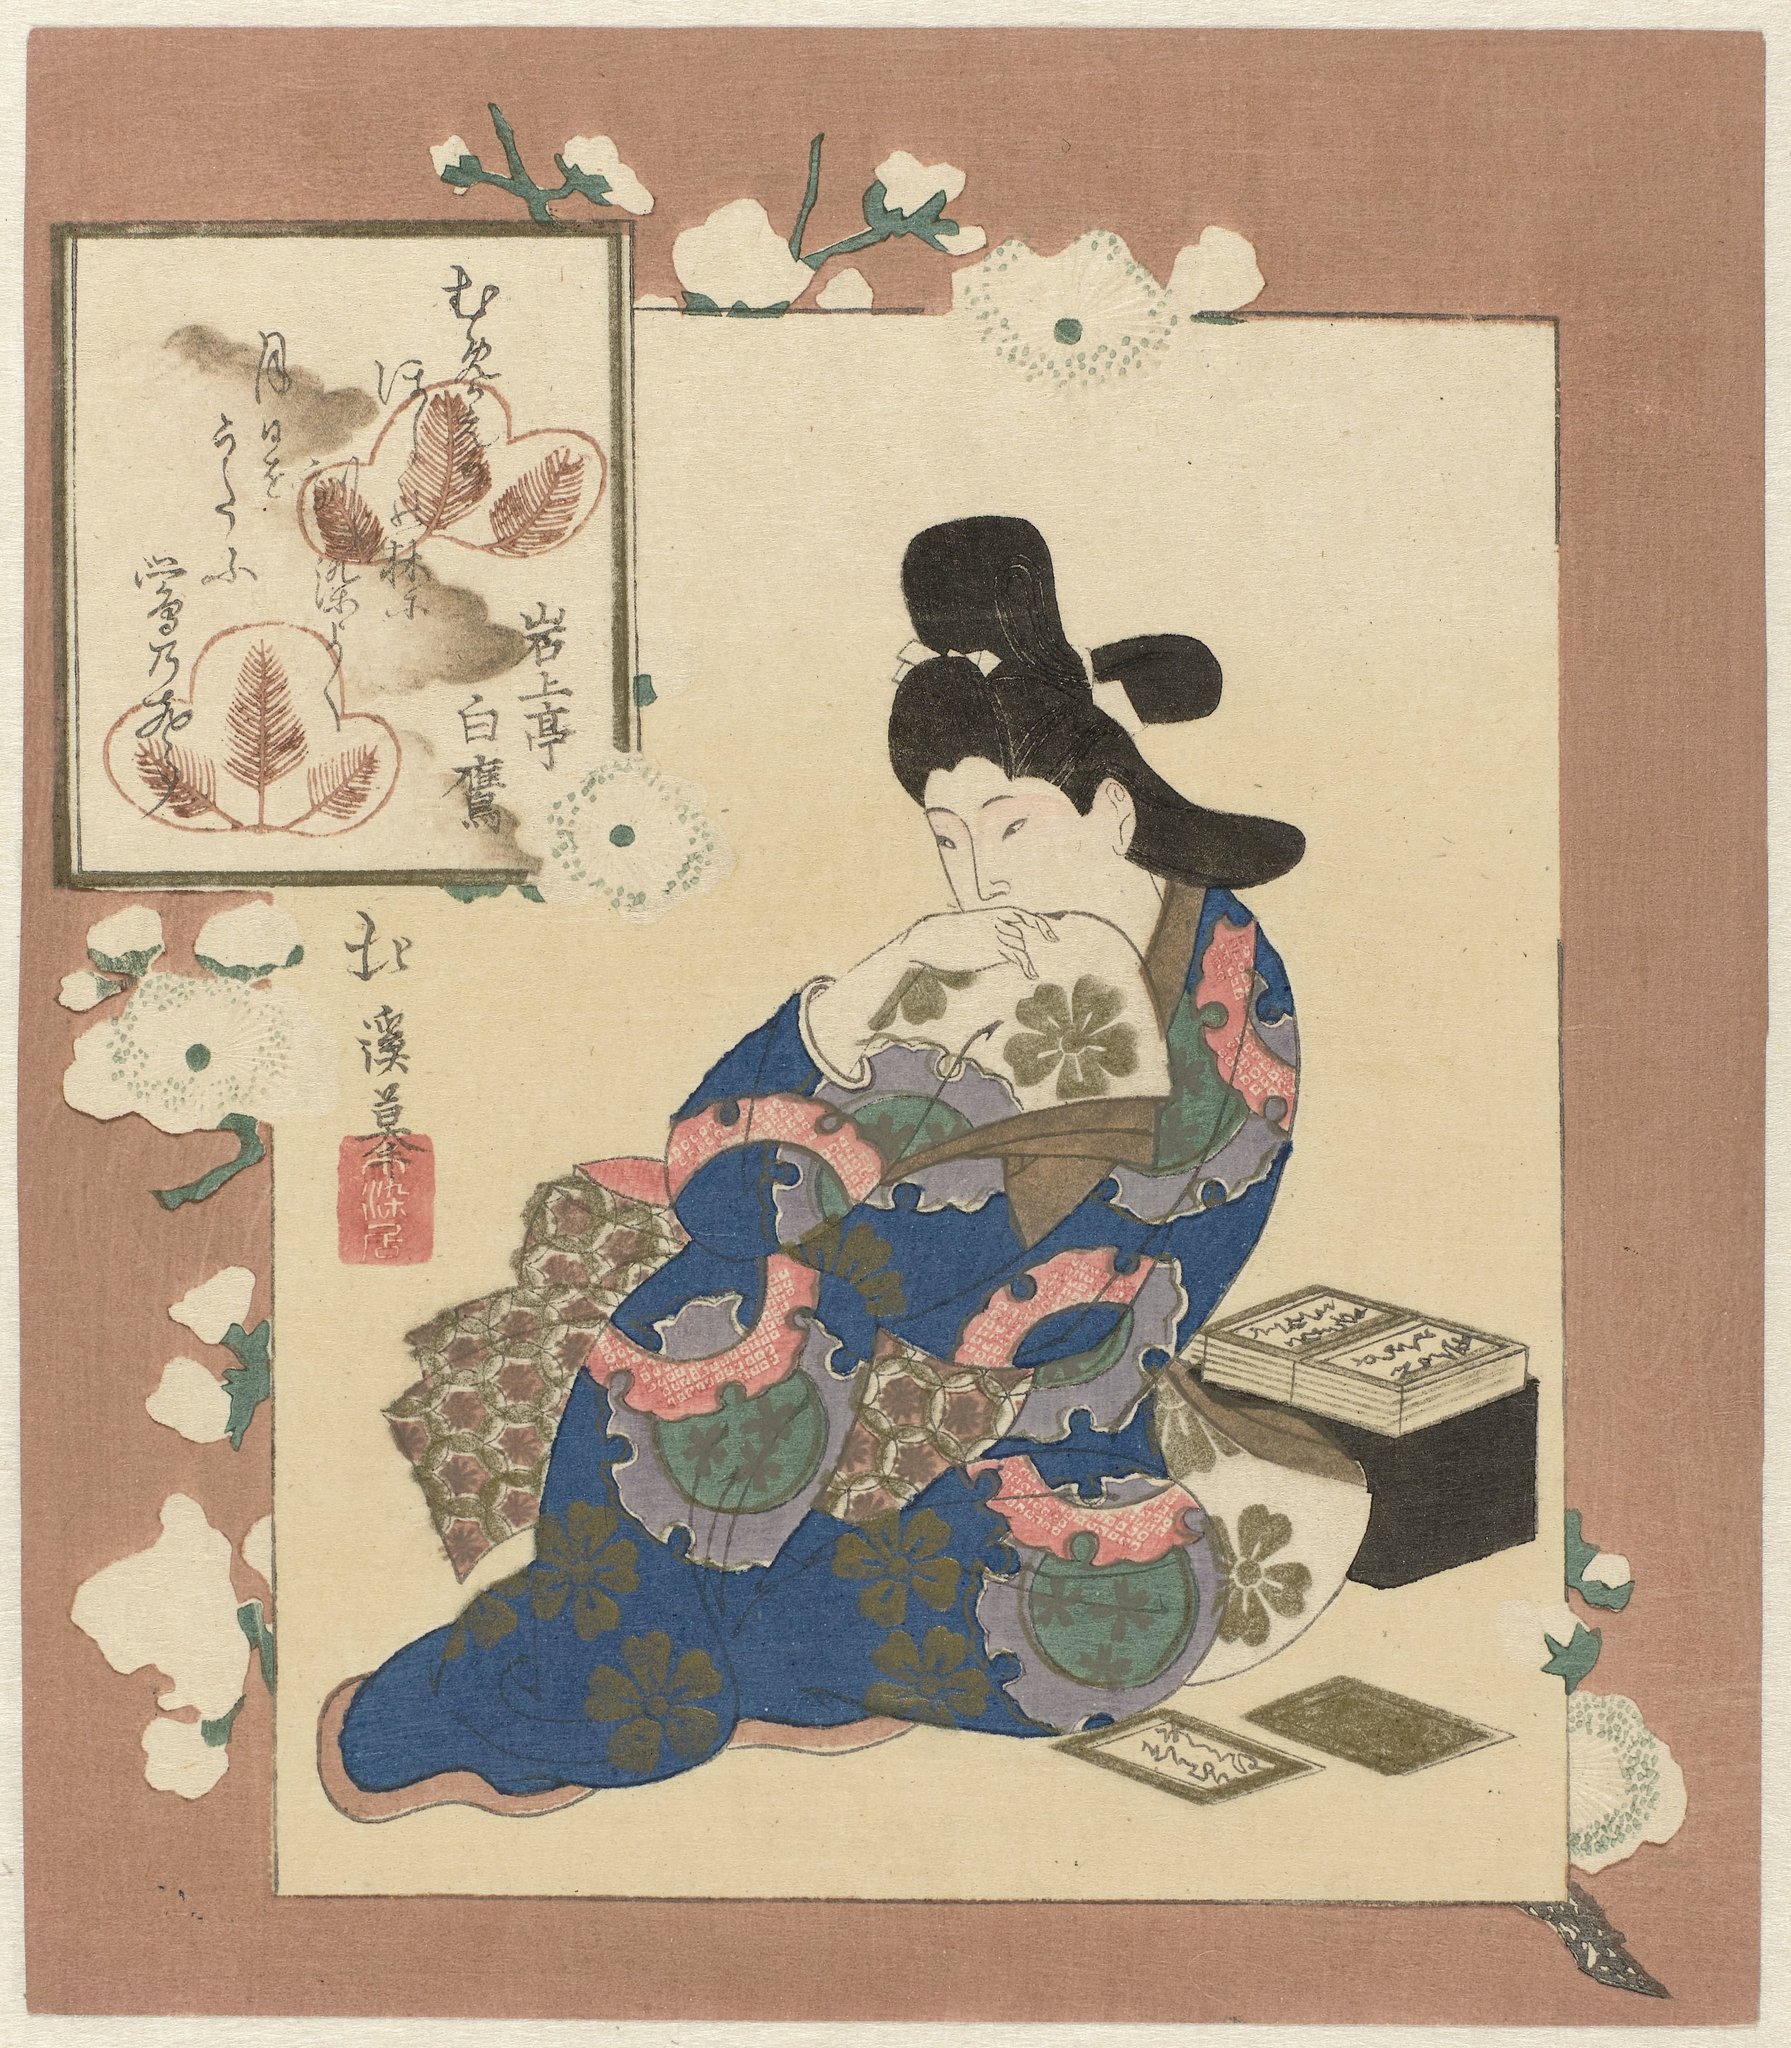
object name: surimono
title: Vrouw met kaarten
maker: totoya hokkei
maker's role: print maker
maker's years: 1790-1850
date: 1890-1900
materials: paper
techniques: blind stamped, woodcut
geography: japan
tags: card games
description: Een surimono is een luxe uitgevoerde prent waarop beeld met één of meerdere gedichten gecombineerd is. Bij het drukken van een surimono werd vaak gebruik gemaakt van dikker papier, blinddruk en metaal pigmenten, zoals koper- en zilverpoeder. De prenten werden vaak in opdracht van dichters gemaakt en als exclusief geschenk aan vrienden en relaties gegeven.